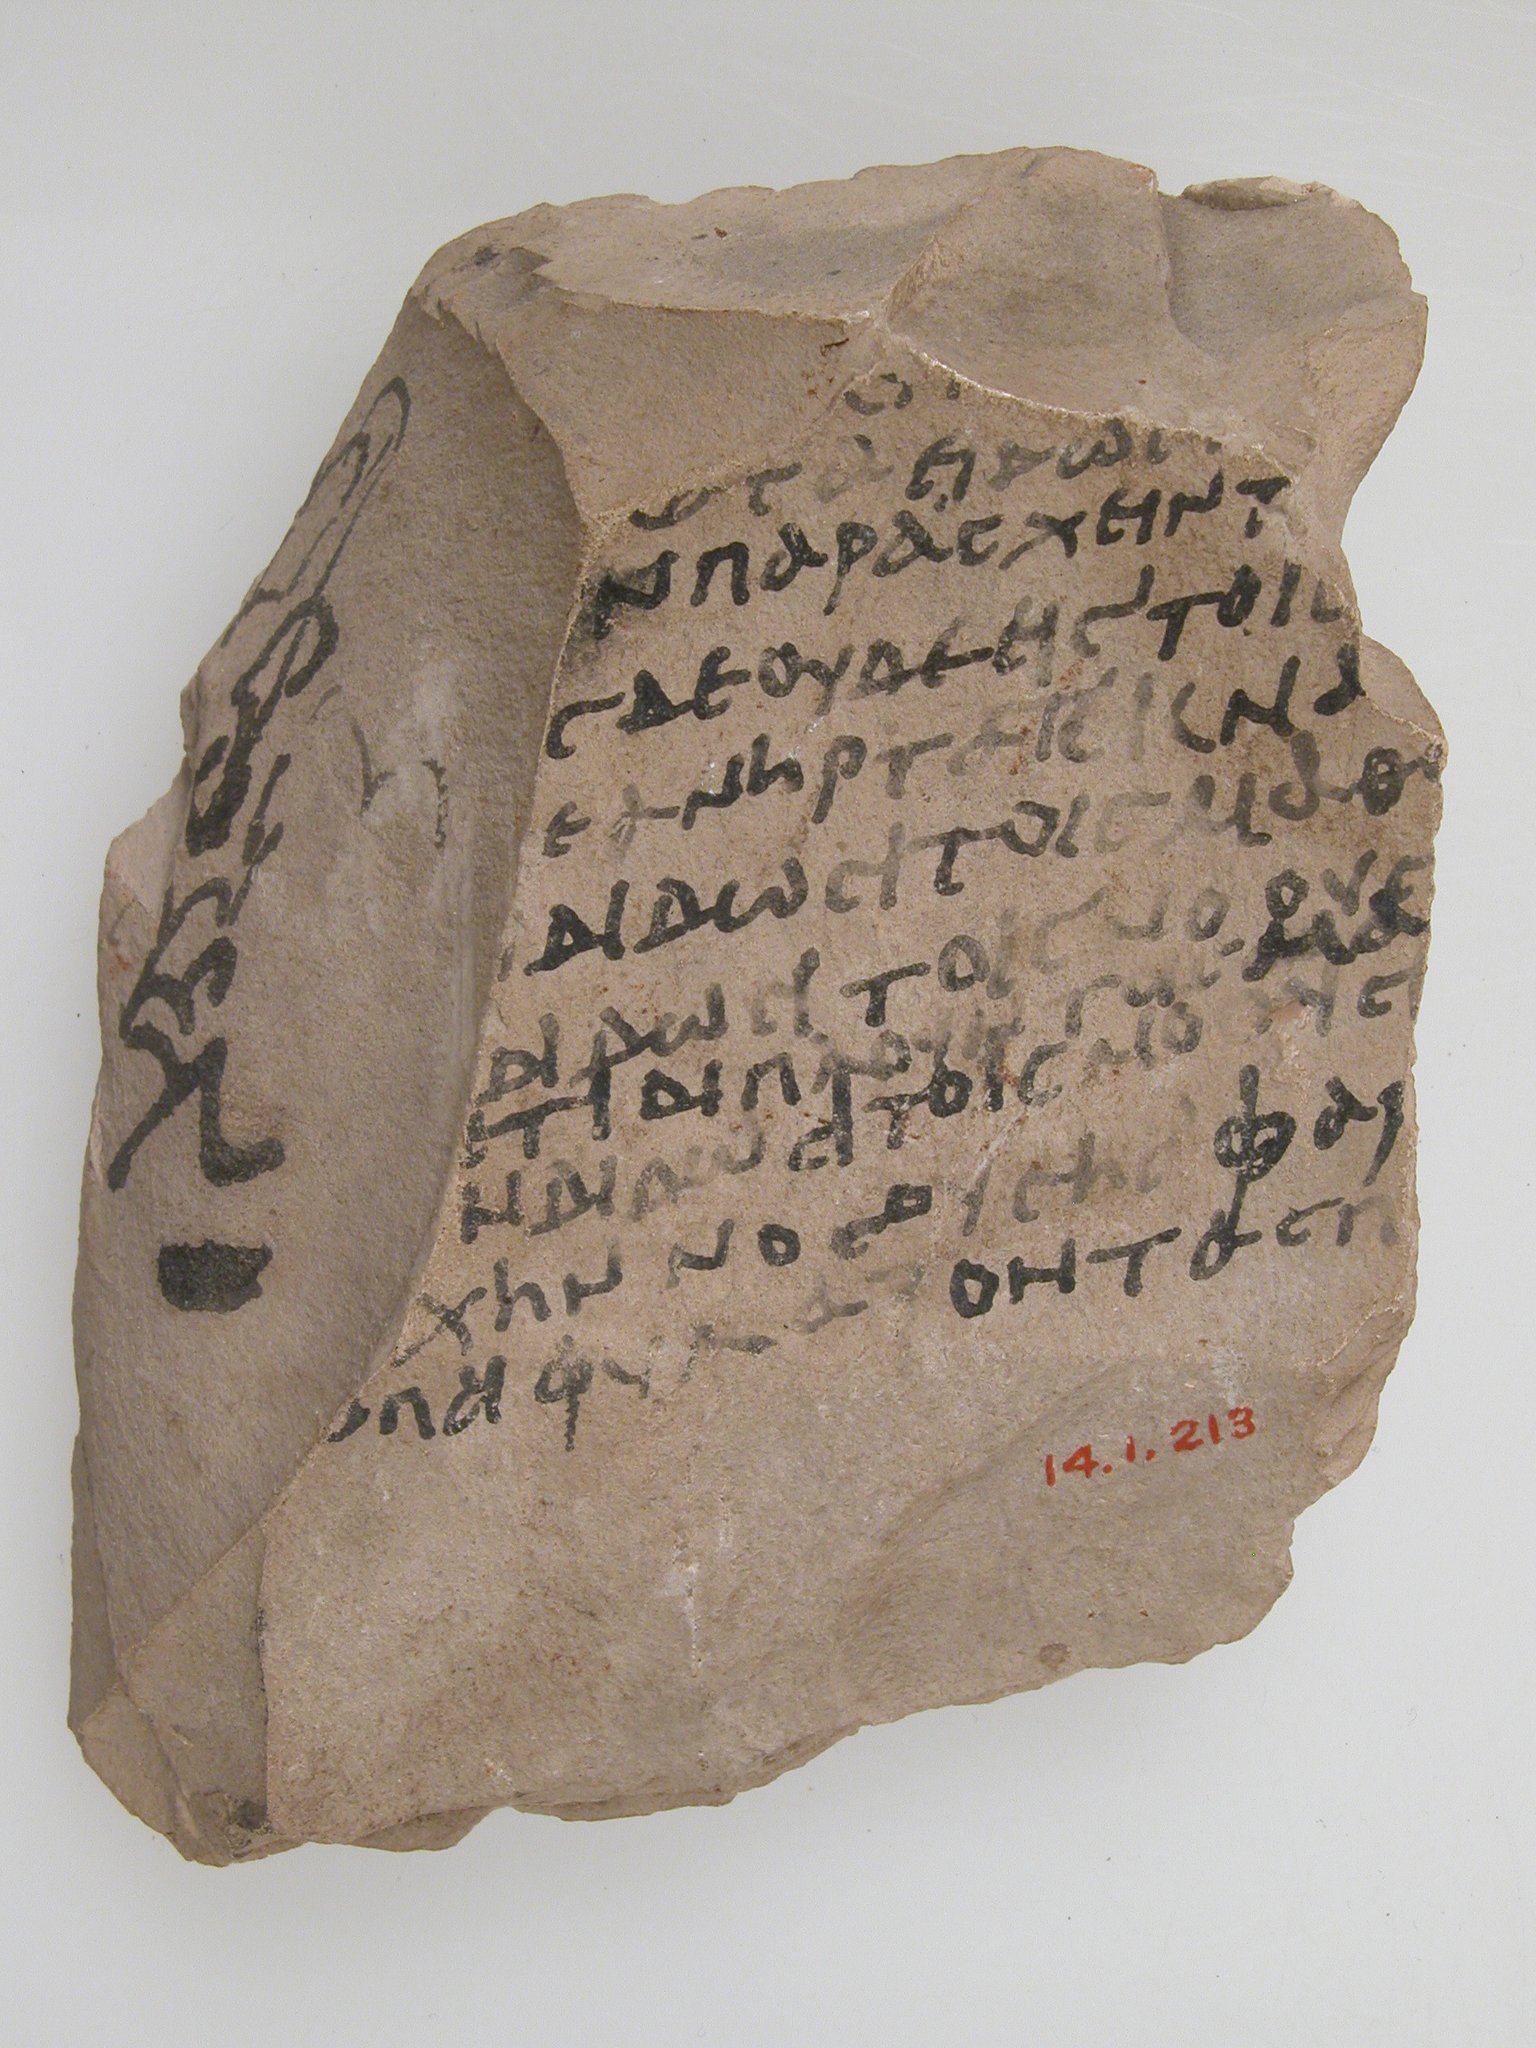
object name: ostrakon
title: Ostrakon with a Homily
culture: coptic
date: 580-640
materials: ink, limestone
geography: egypt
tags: documents,greek